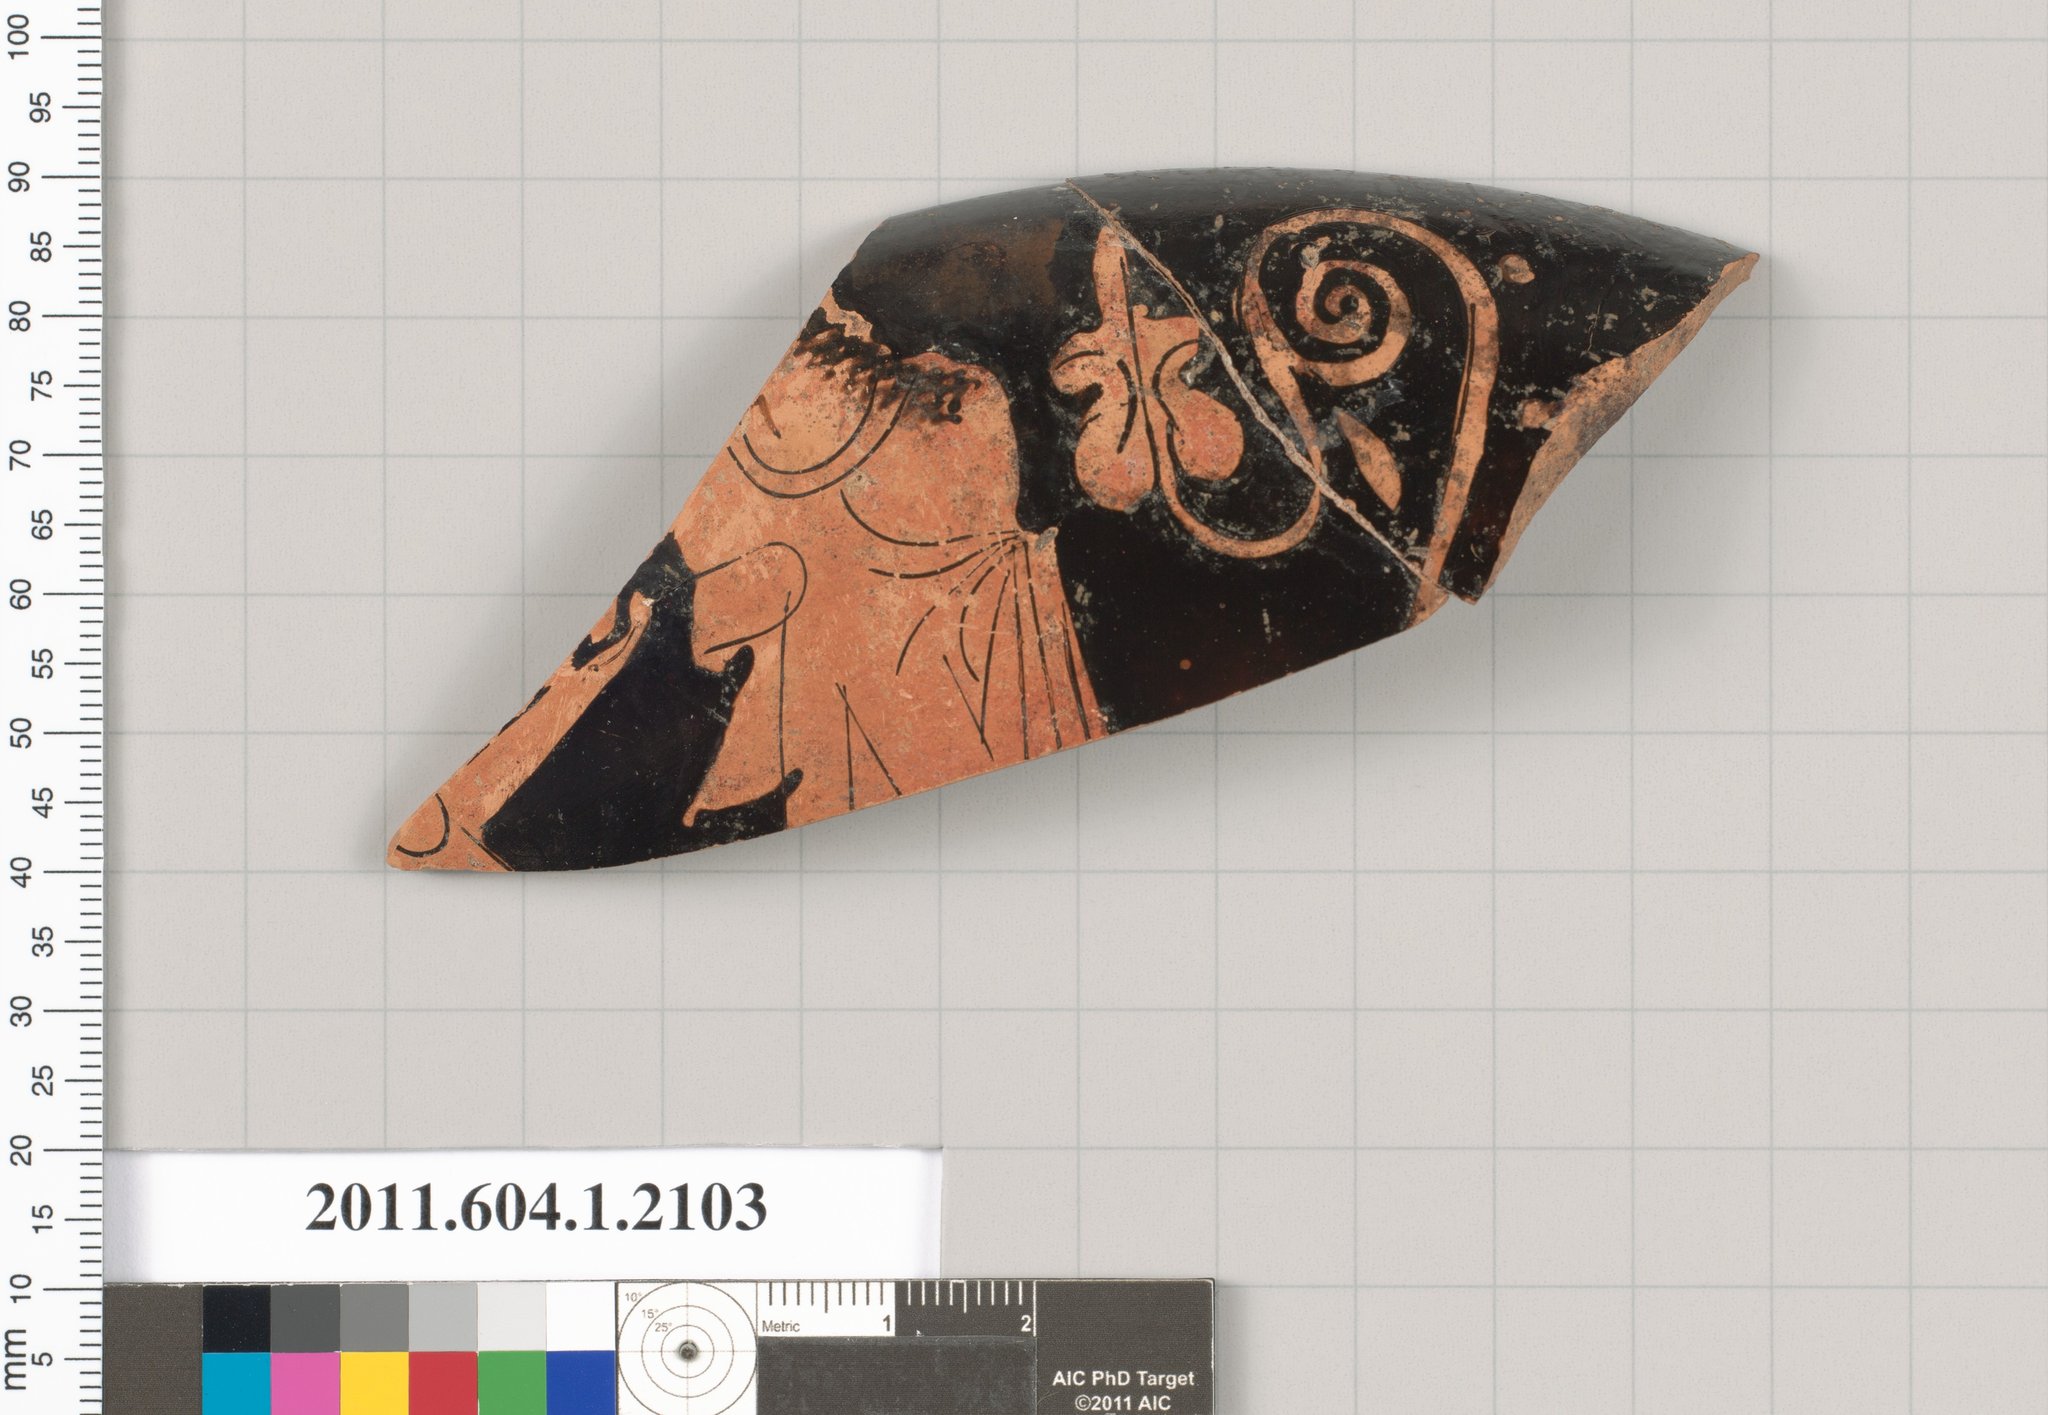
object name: kylix fragment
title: Terracotta rim fragment of a kylix (drinking cup)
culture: greek, attic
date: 467-435 BCE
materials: terracotta